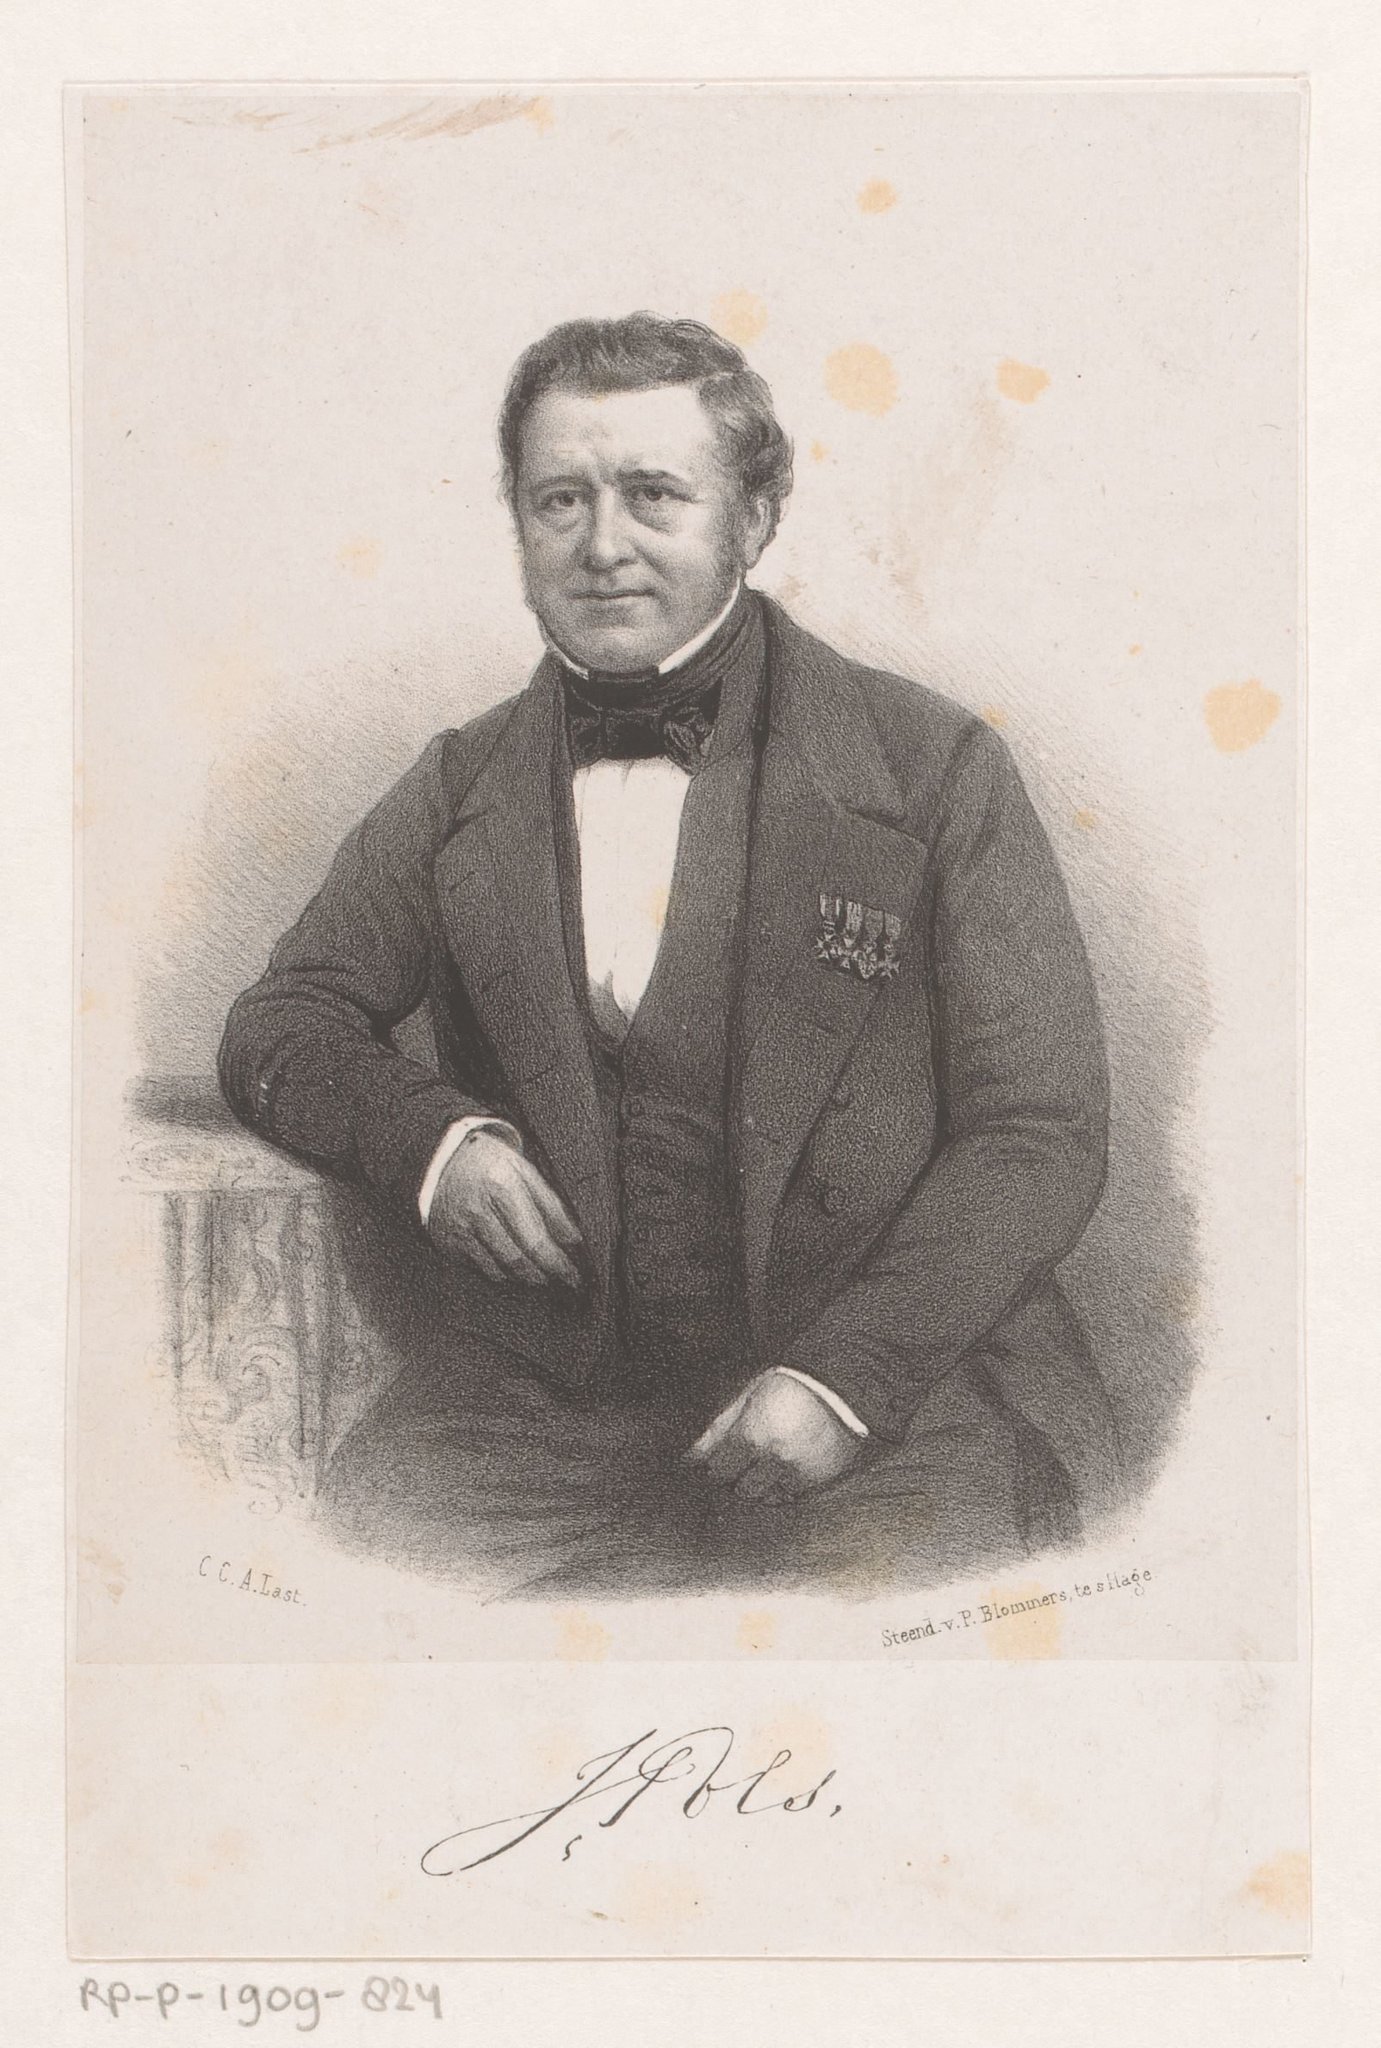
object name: print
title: Portret van Jacques Pols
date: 1842-1864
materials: paper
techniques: lithograph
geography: the hague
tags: knighthood order, historical persons (+ half-length portrait)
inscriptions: collector's mark: Lugt 2228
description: De geportretteerde zit en leunt met zijn rechterarm op een tafel. Hij draagt vier ridderorden. Onder het portret zijn signatuur.